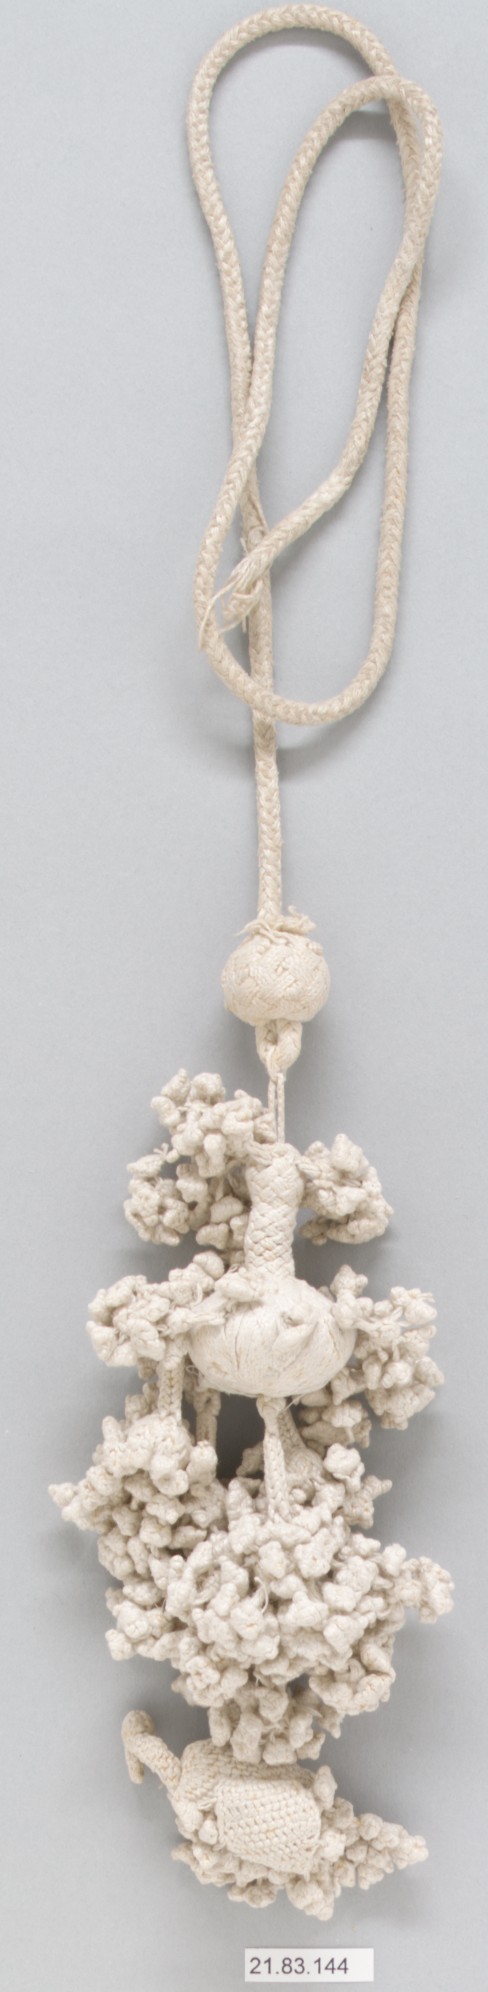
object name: tassel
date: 1601-1700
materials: linen